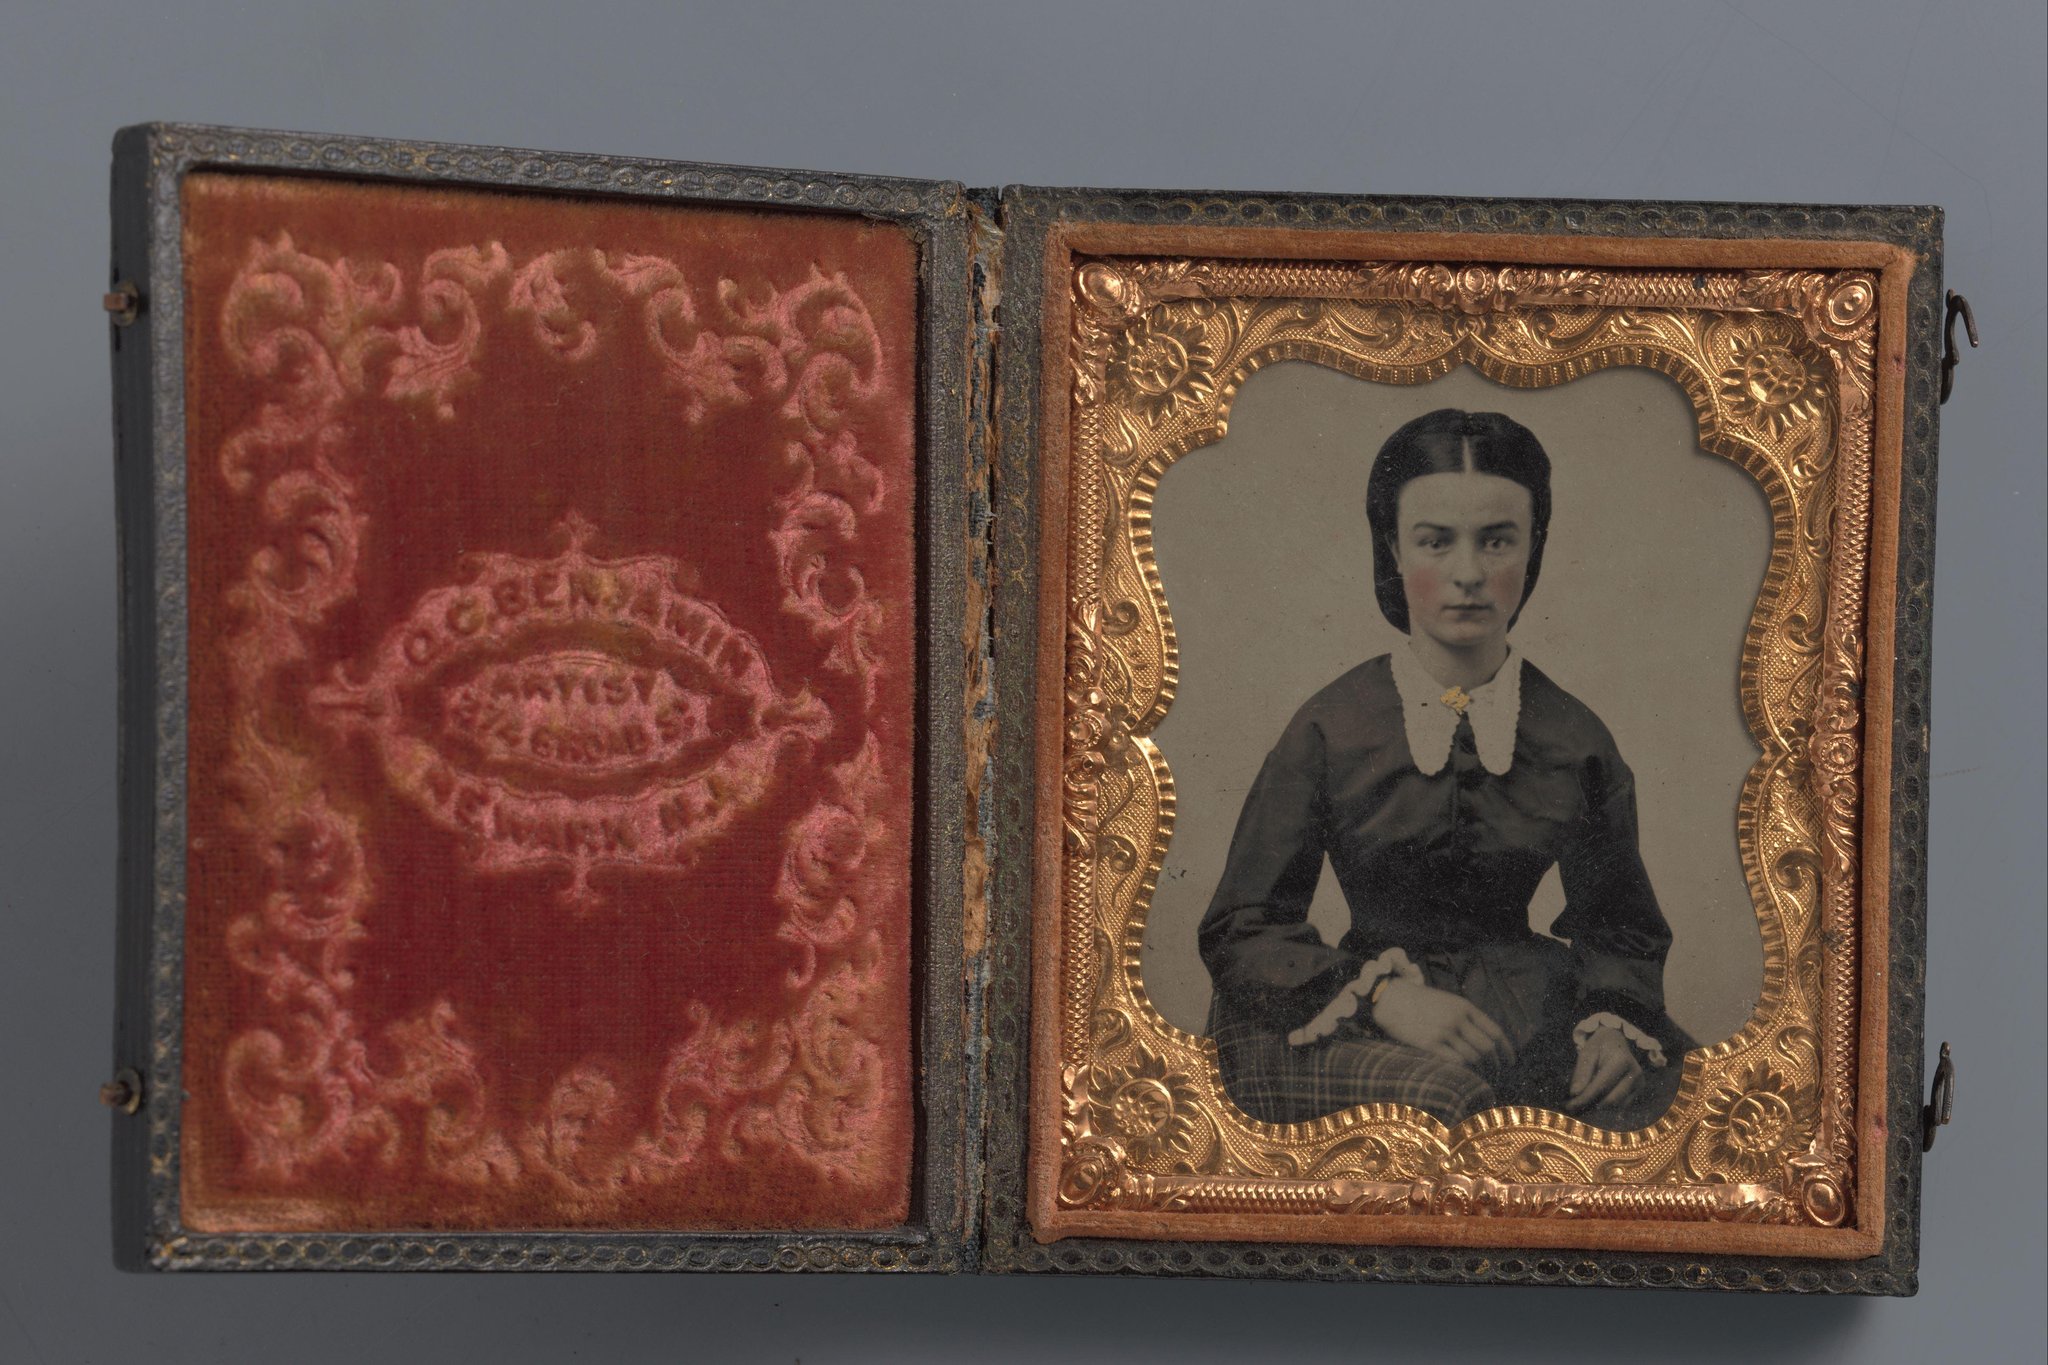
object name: photograph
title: Portret van een onbekende jonge vrouw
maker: orrin c. benjamin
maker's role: fotograaf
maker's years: 1827-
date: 1855-1900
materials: cardboard, glass, iron, metal, paper, textile, wood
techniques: ferrotyping, hand coloring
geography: newark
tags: adolescent, young woman, maiden, historical persons - bb - woman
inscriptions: inscription: ‘O.C. Benjamin/ Artist/ 274 Broad St./ Newark N.J.’